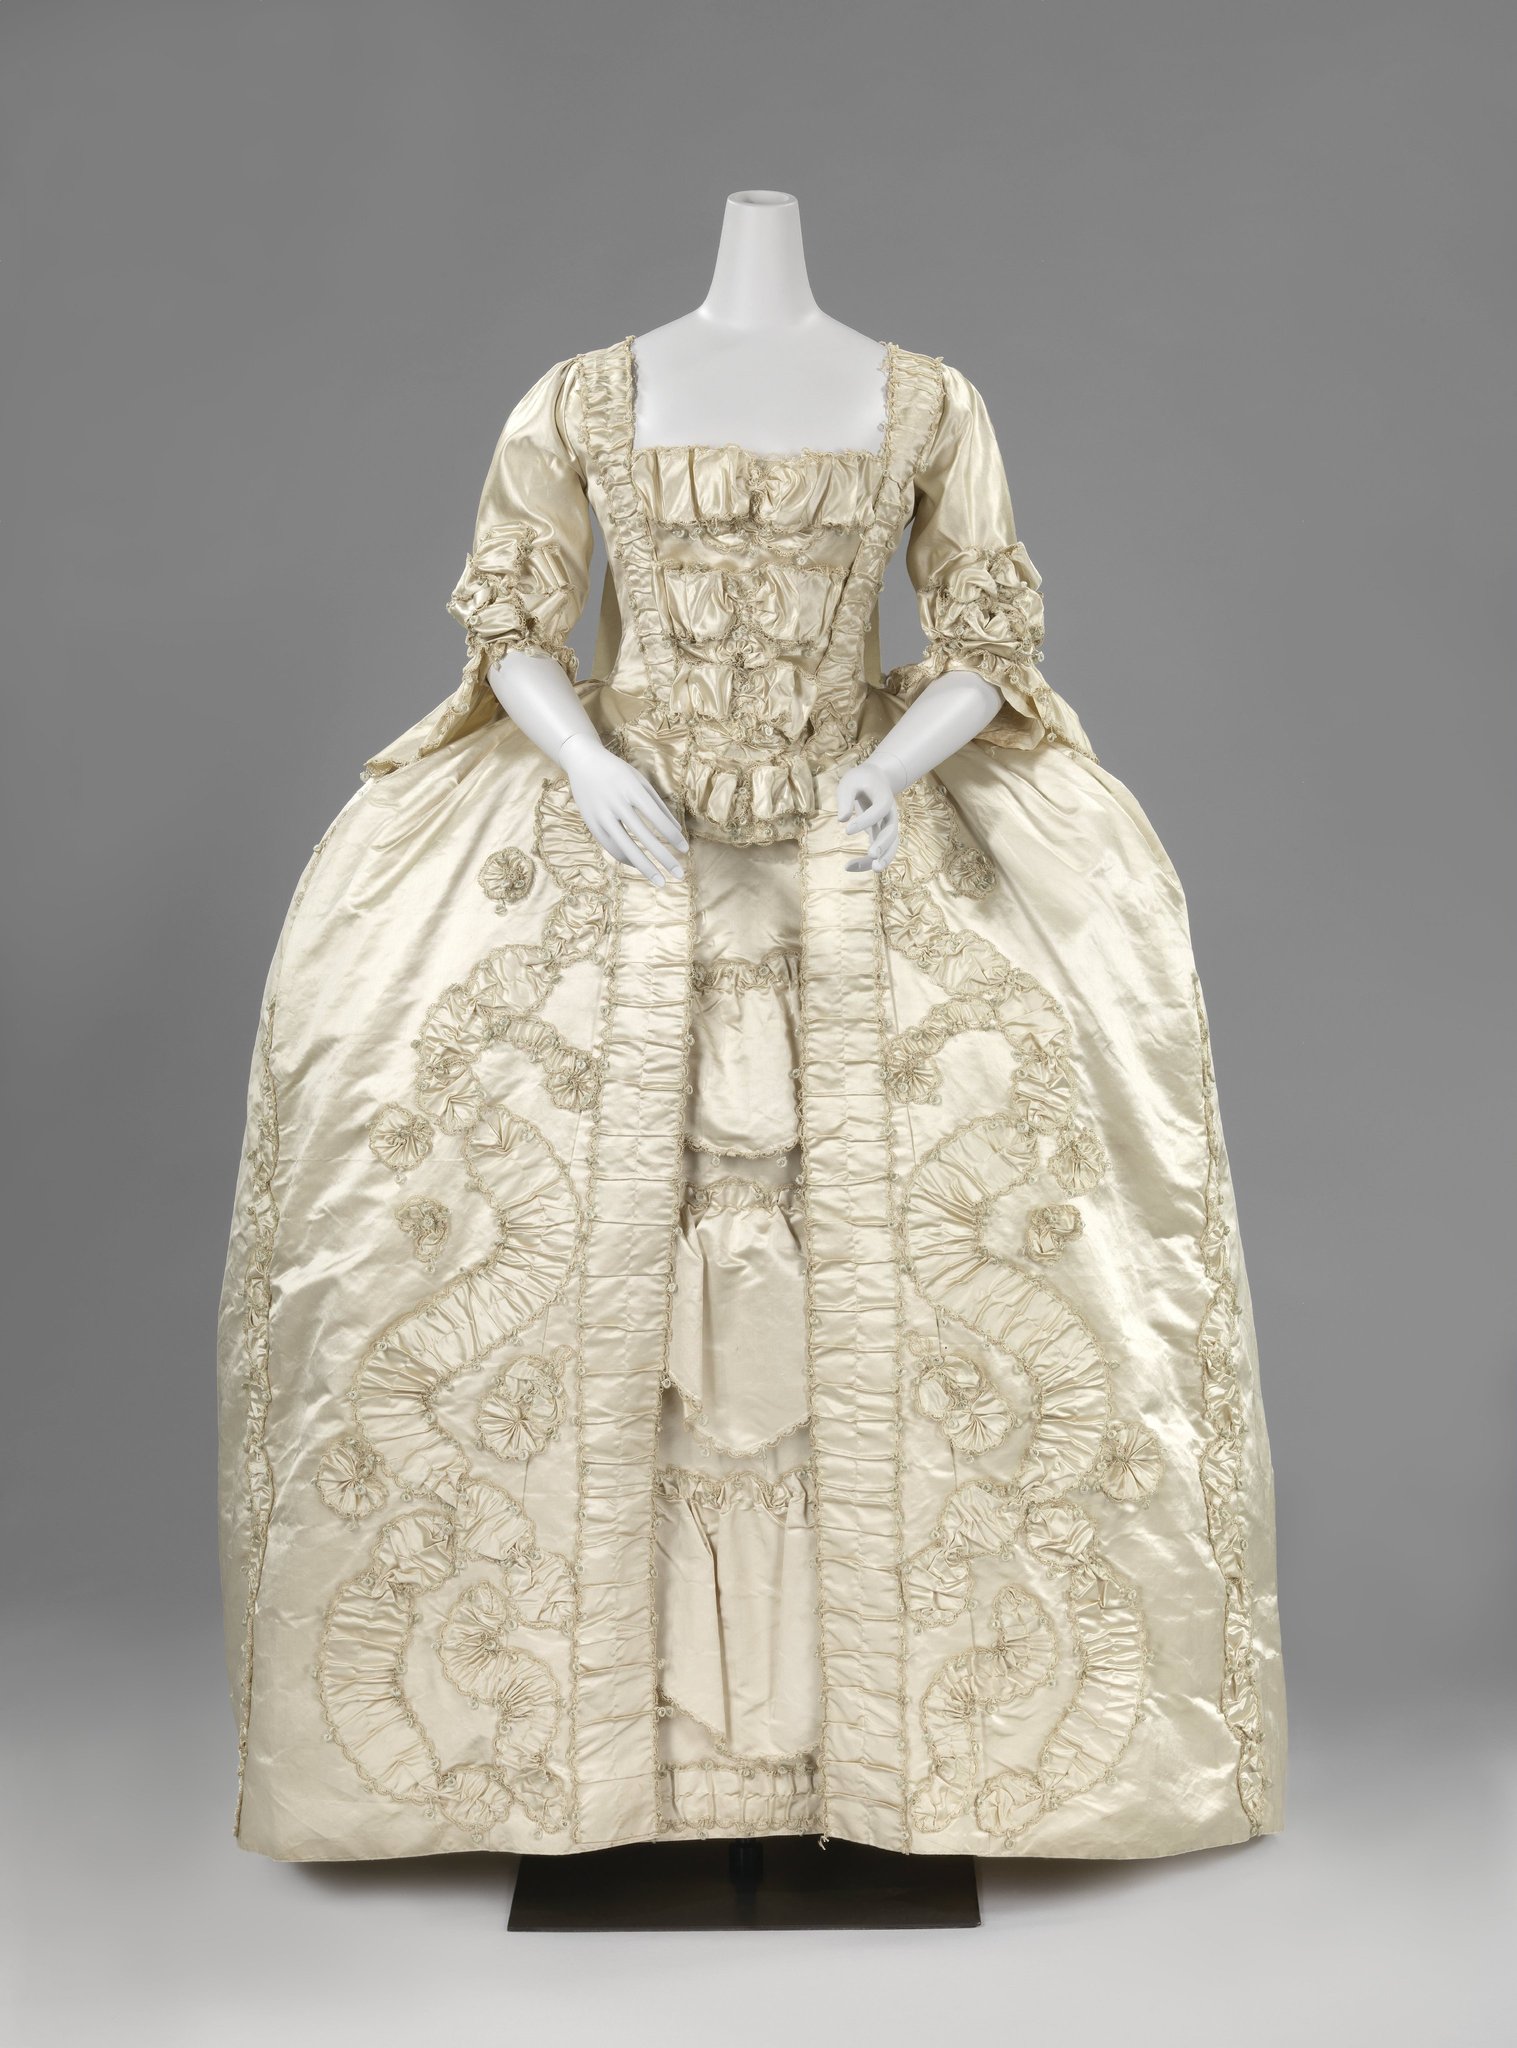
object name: womenswear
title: Sack-Back Gown (robe à la française)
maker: Anonymous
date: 1760-1765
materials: linen, silk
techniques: weave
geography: netherlands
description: While this dress may look like a wedding gown to us, it was not at all customary to marry in white in the 18th century. In this period, many Dutch ladies were portrayed garbed in creamy white silk gowns. Notable here is the v shaped pièce, or stomacher, which is as profusely decorated as the rest of the dress.